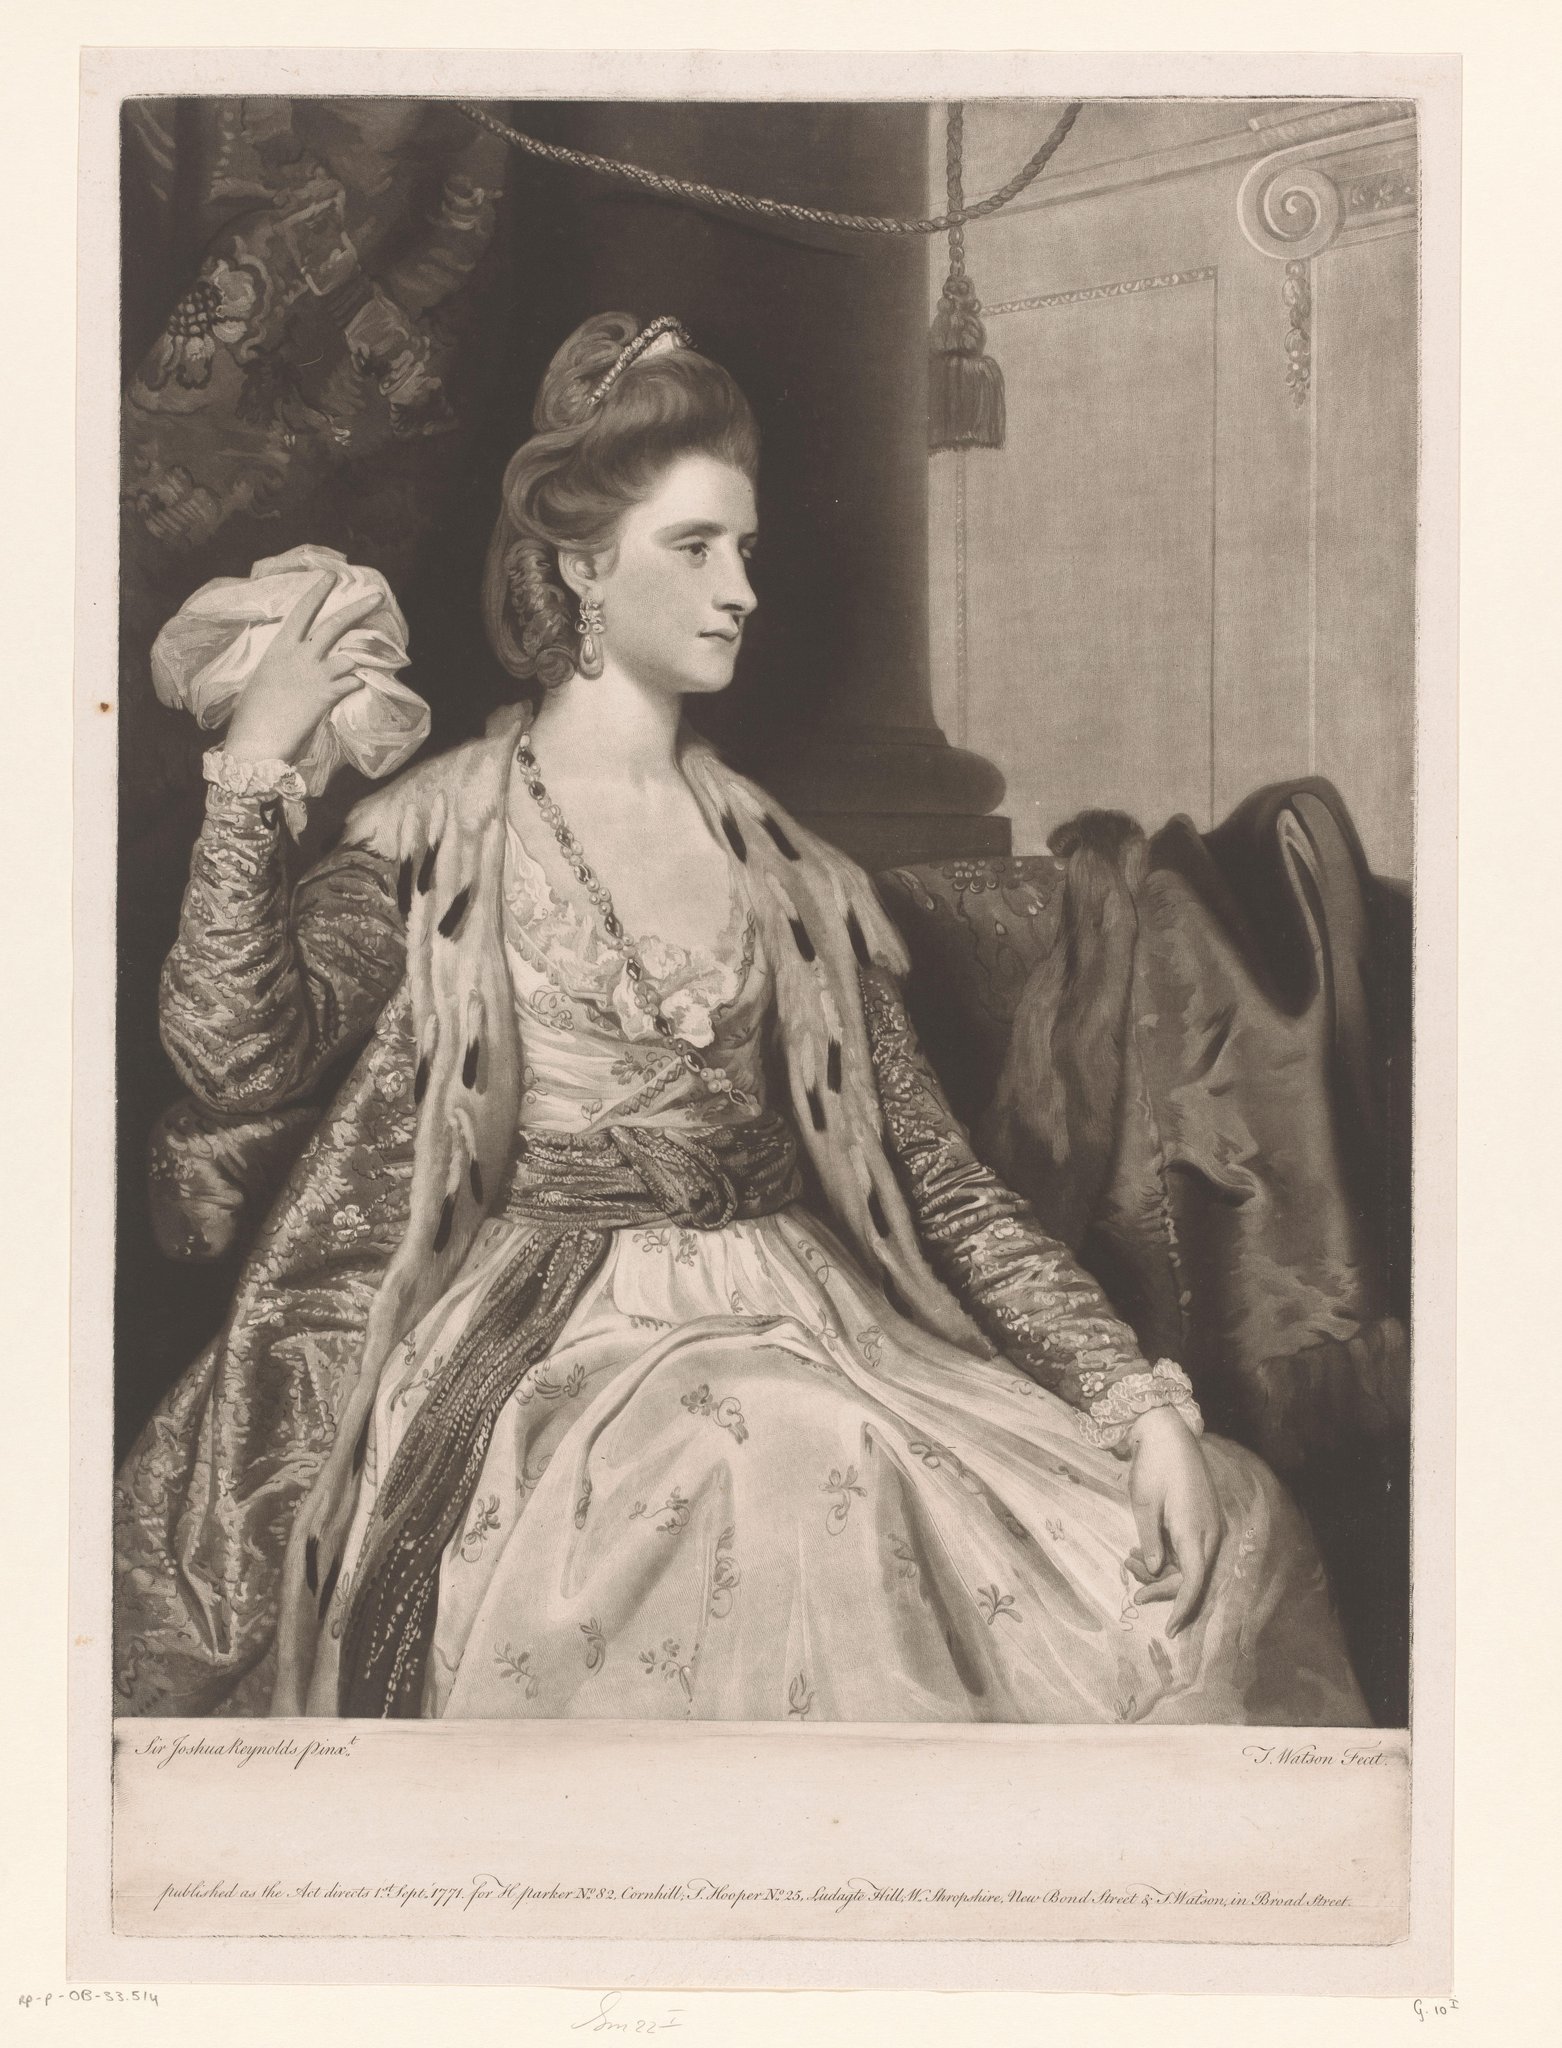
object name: print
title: Portret van Polly Kennedy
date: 1709-1771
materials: paper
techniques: mezzotint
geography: london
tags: historical persons - bb - woman, handkerchief, pearl; pearl necklace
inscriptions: collector's mark: Lugt 240